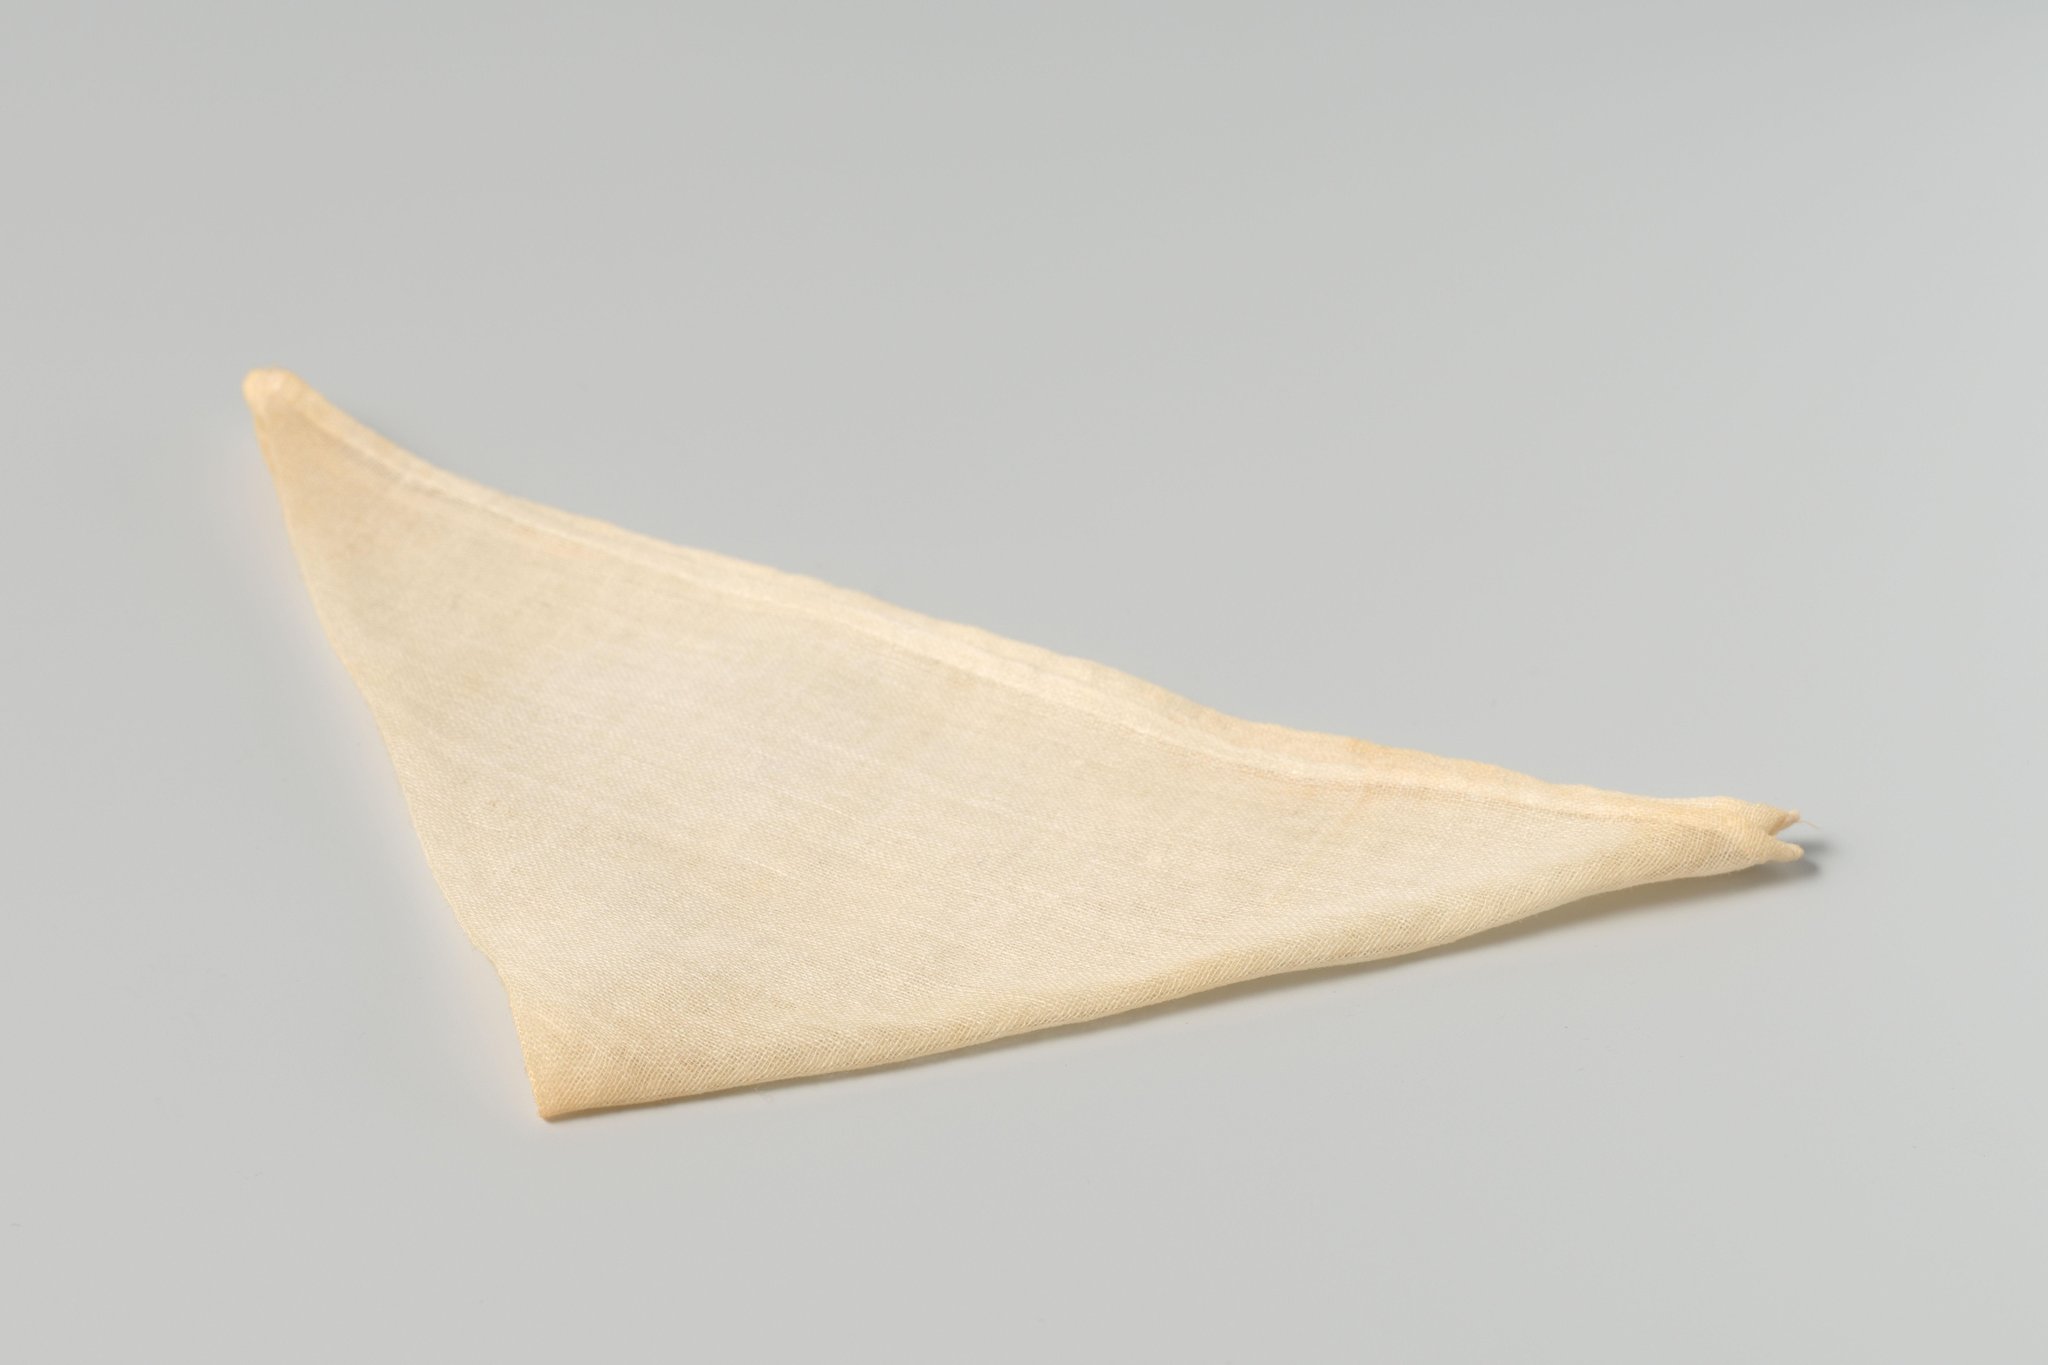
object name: miniature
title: Doek van linnen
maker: Anonymous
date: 1676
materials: linen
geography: netherlands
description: Doek van fijn linnen, vierkant, aan alle zijden voorzien van een fijne zoom.